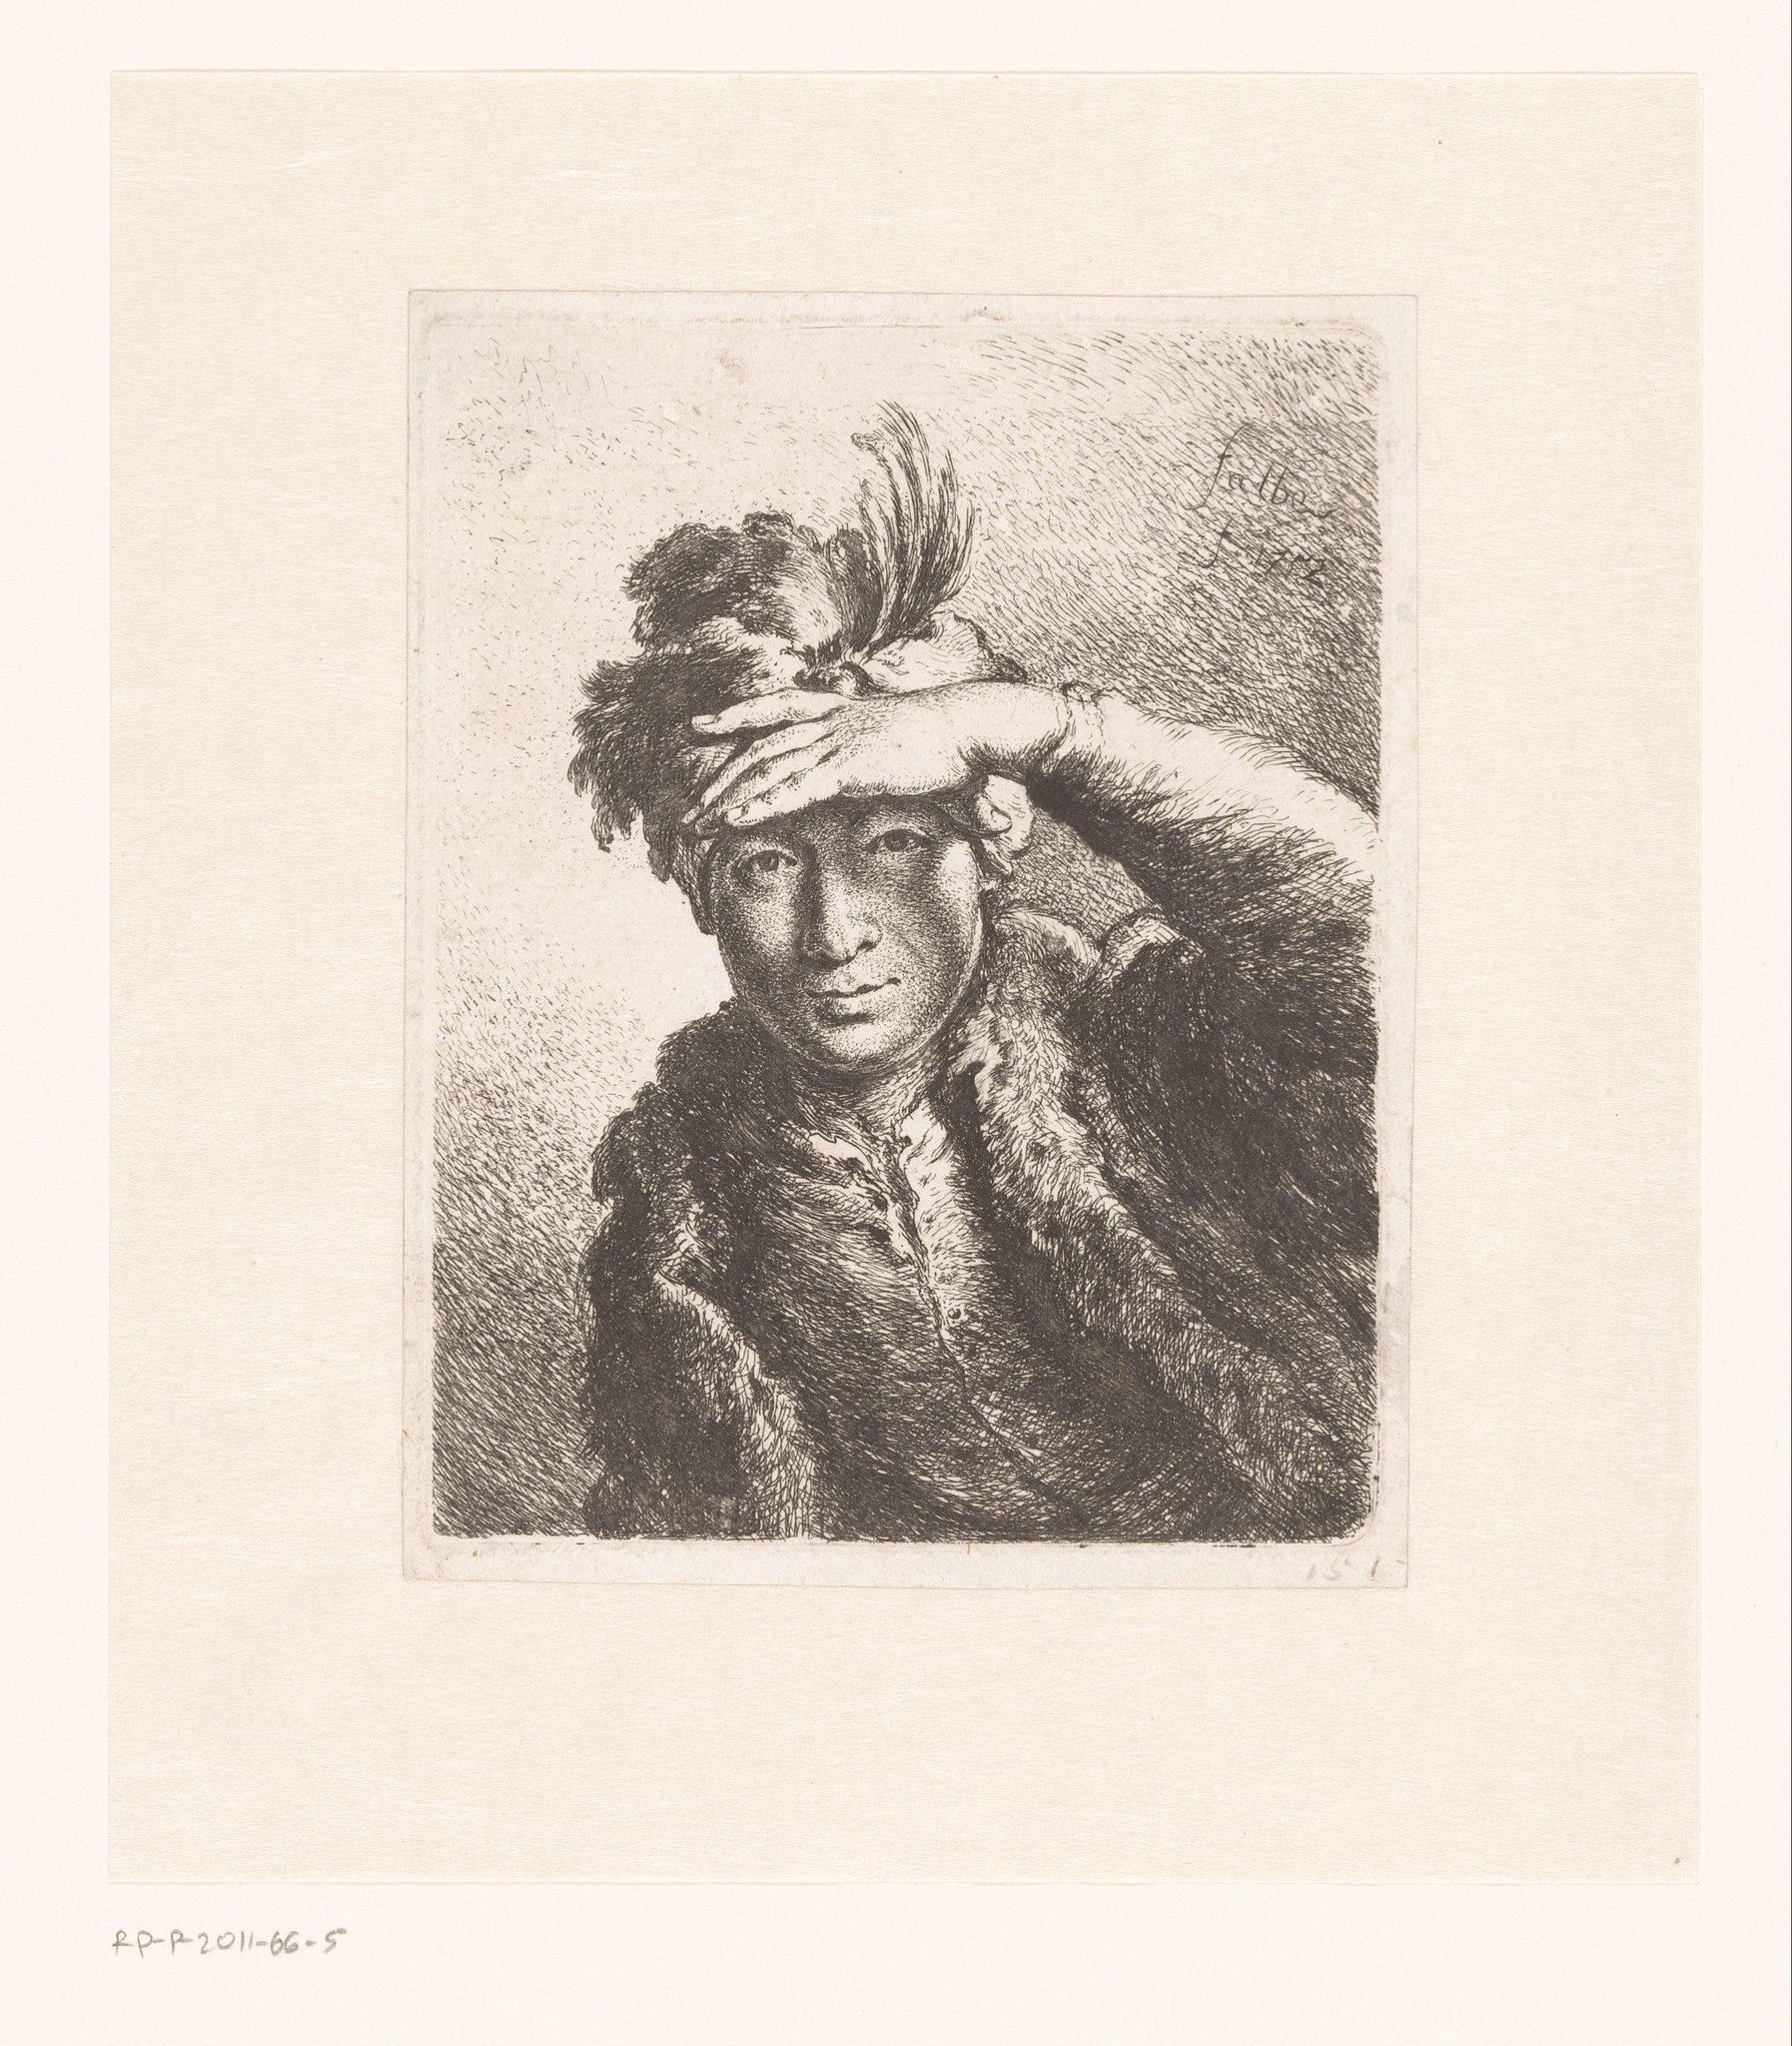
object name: print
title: Portret van een man met een gevederde baret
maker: joachim martin falbe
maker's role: print maker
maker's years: 1709-1782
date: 1752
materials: paper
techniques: etching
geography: berlin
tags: historical persons, head-gear: beret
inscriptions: collector's mark: Lugt 2760, collector's mark: Lugt 2228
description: Portret van een man met gevederde baret die met zijn linkerhand zijn ogen beschermt tegen het licht. Mogelijk een zelfportret.